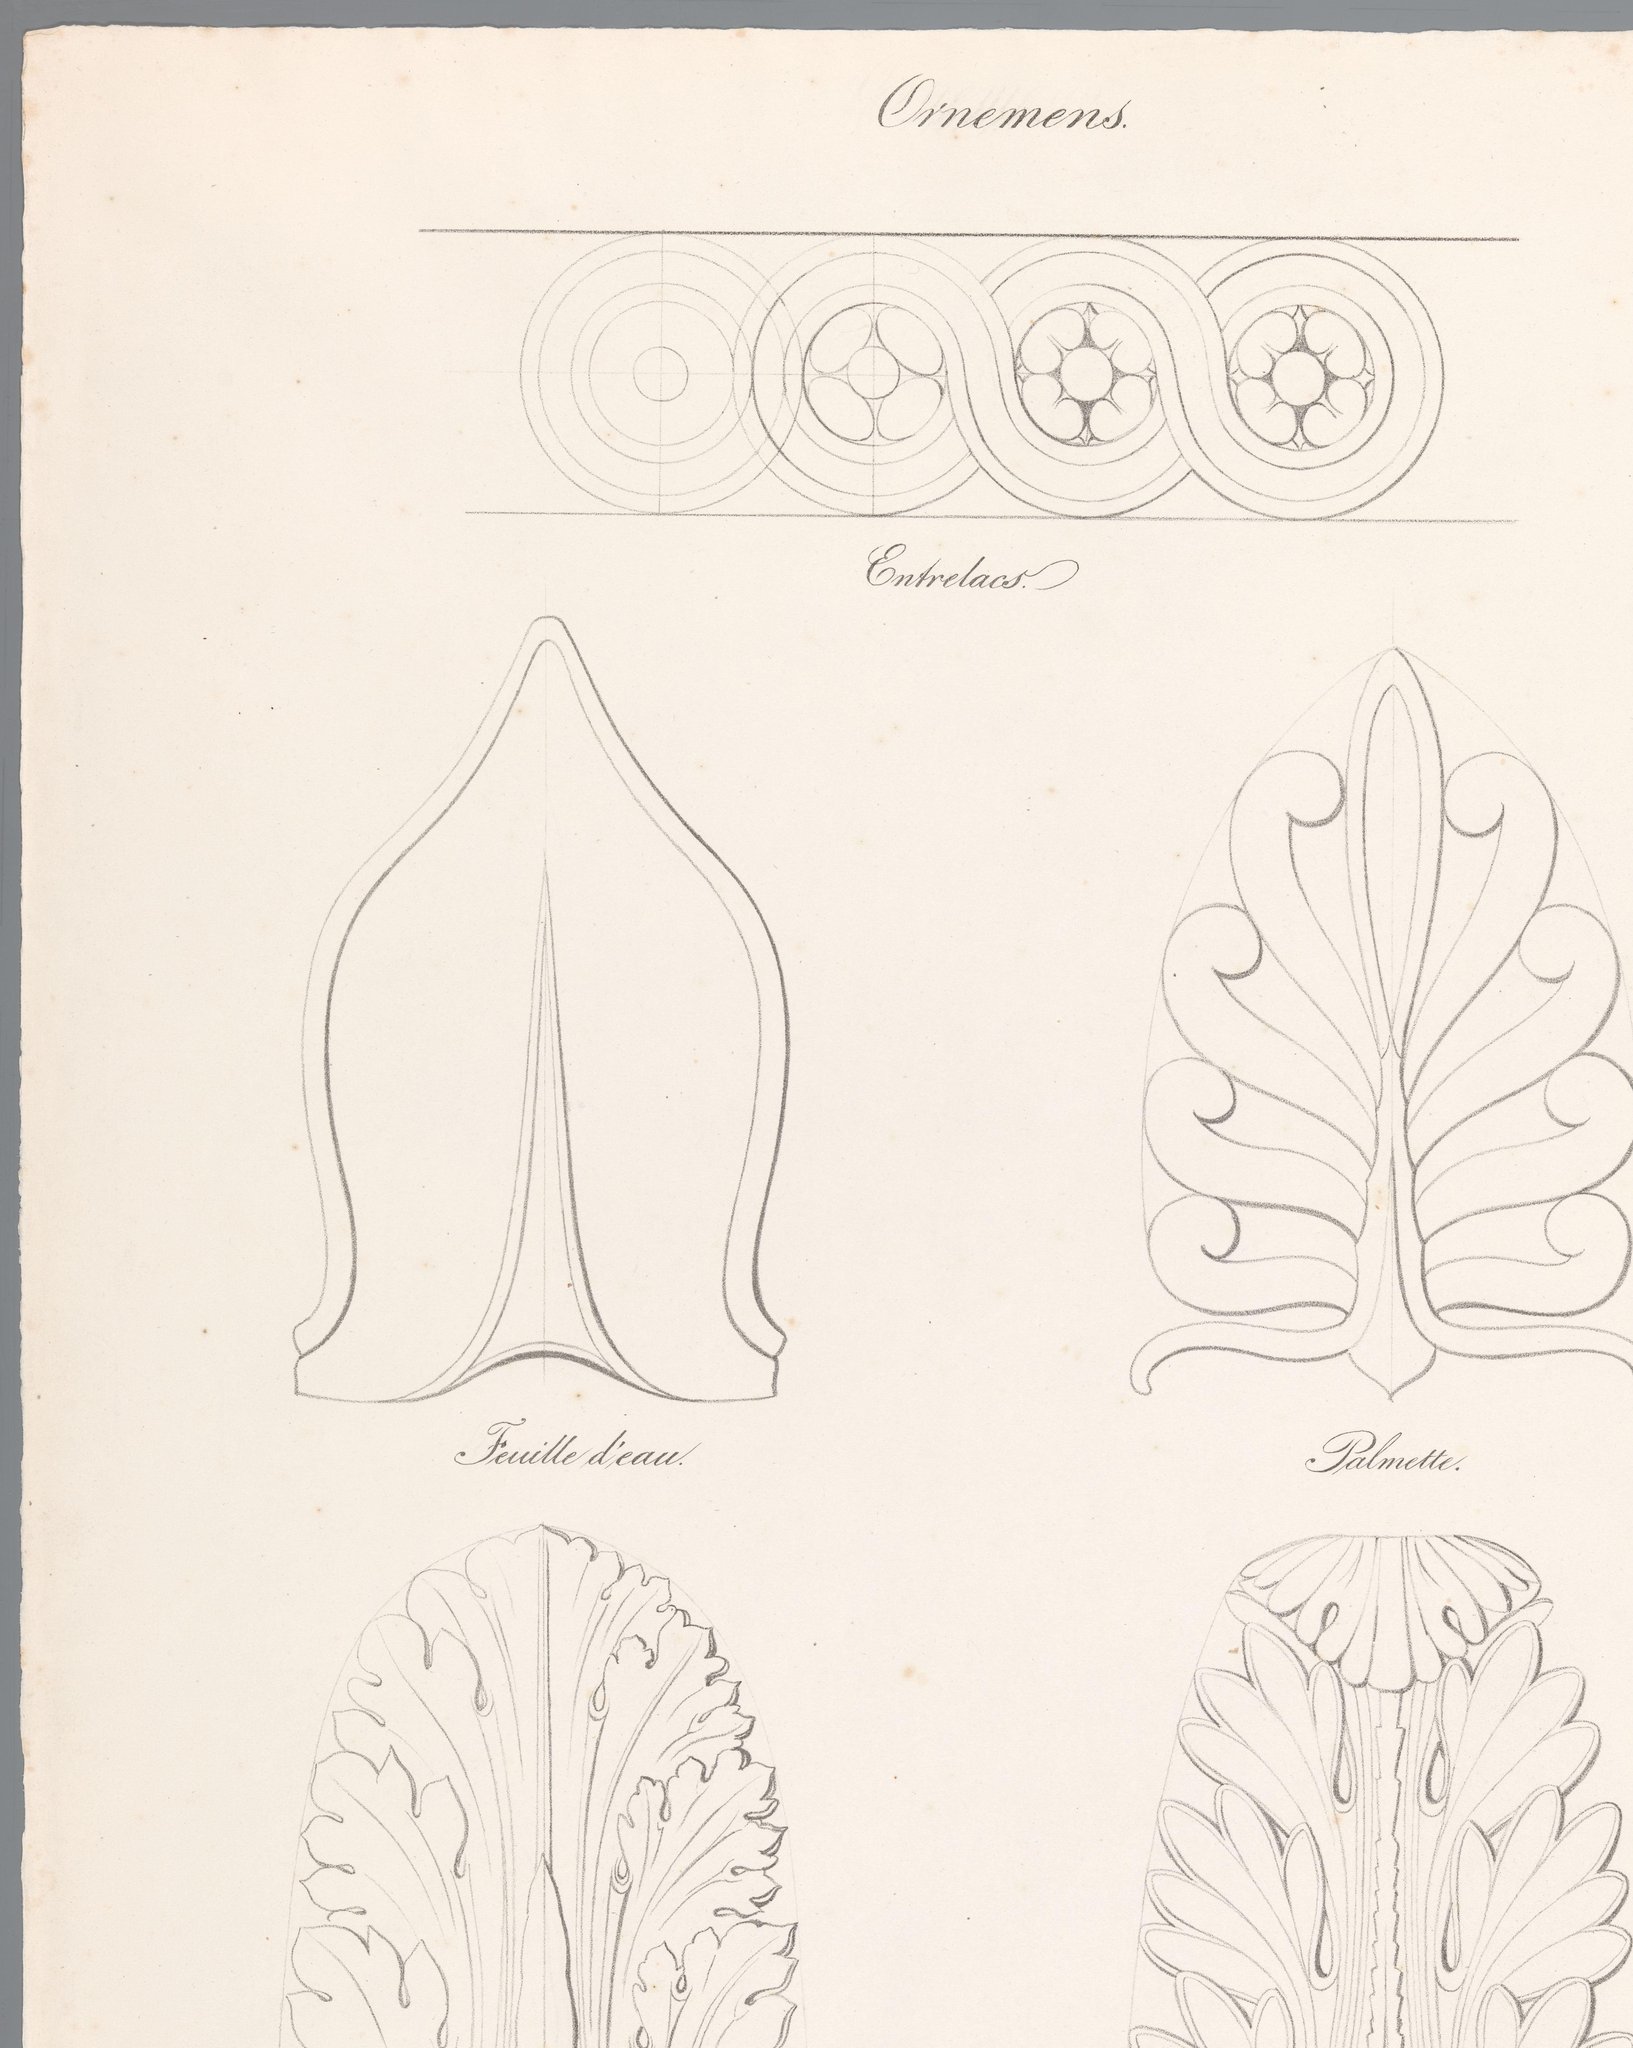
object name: print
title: Cours de dessin-ornemens à L'usage des Eleves qui se destinent à l'étude des Beaux-Arts et à la pratique des Arts mécaniques. Formé de tous les meilleurs genres de modèles, antiques et modernes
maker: jean augustin daiwaille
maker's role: draughtsman, print maker, printer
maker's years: 1786-1850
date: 1820-1833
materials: paper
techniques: lithograph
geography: amsterdam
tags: palmette ~ ornament, acanthus ~ ornament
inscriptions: collector's mark: Lugt 2228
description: Afgebeeld zijn vier soorten bladeren: feuille d'eau, palmet, acanthusblad en olijfblad. Bovenin een sierlijst. Genummerd rechtsboven: No. 1. Deze prent maakt deel uit van een omslag met een titelblad en zes prenten.